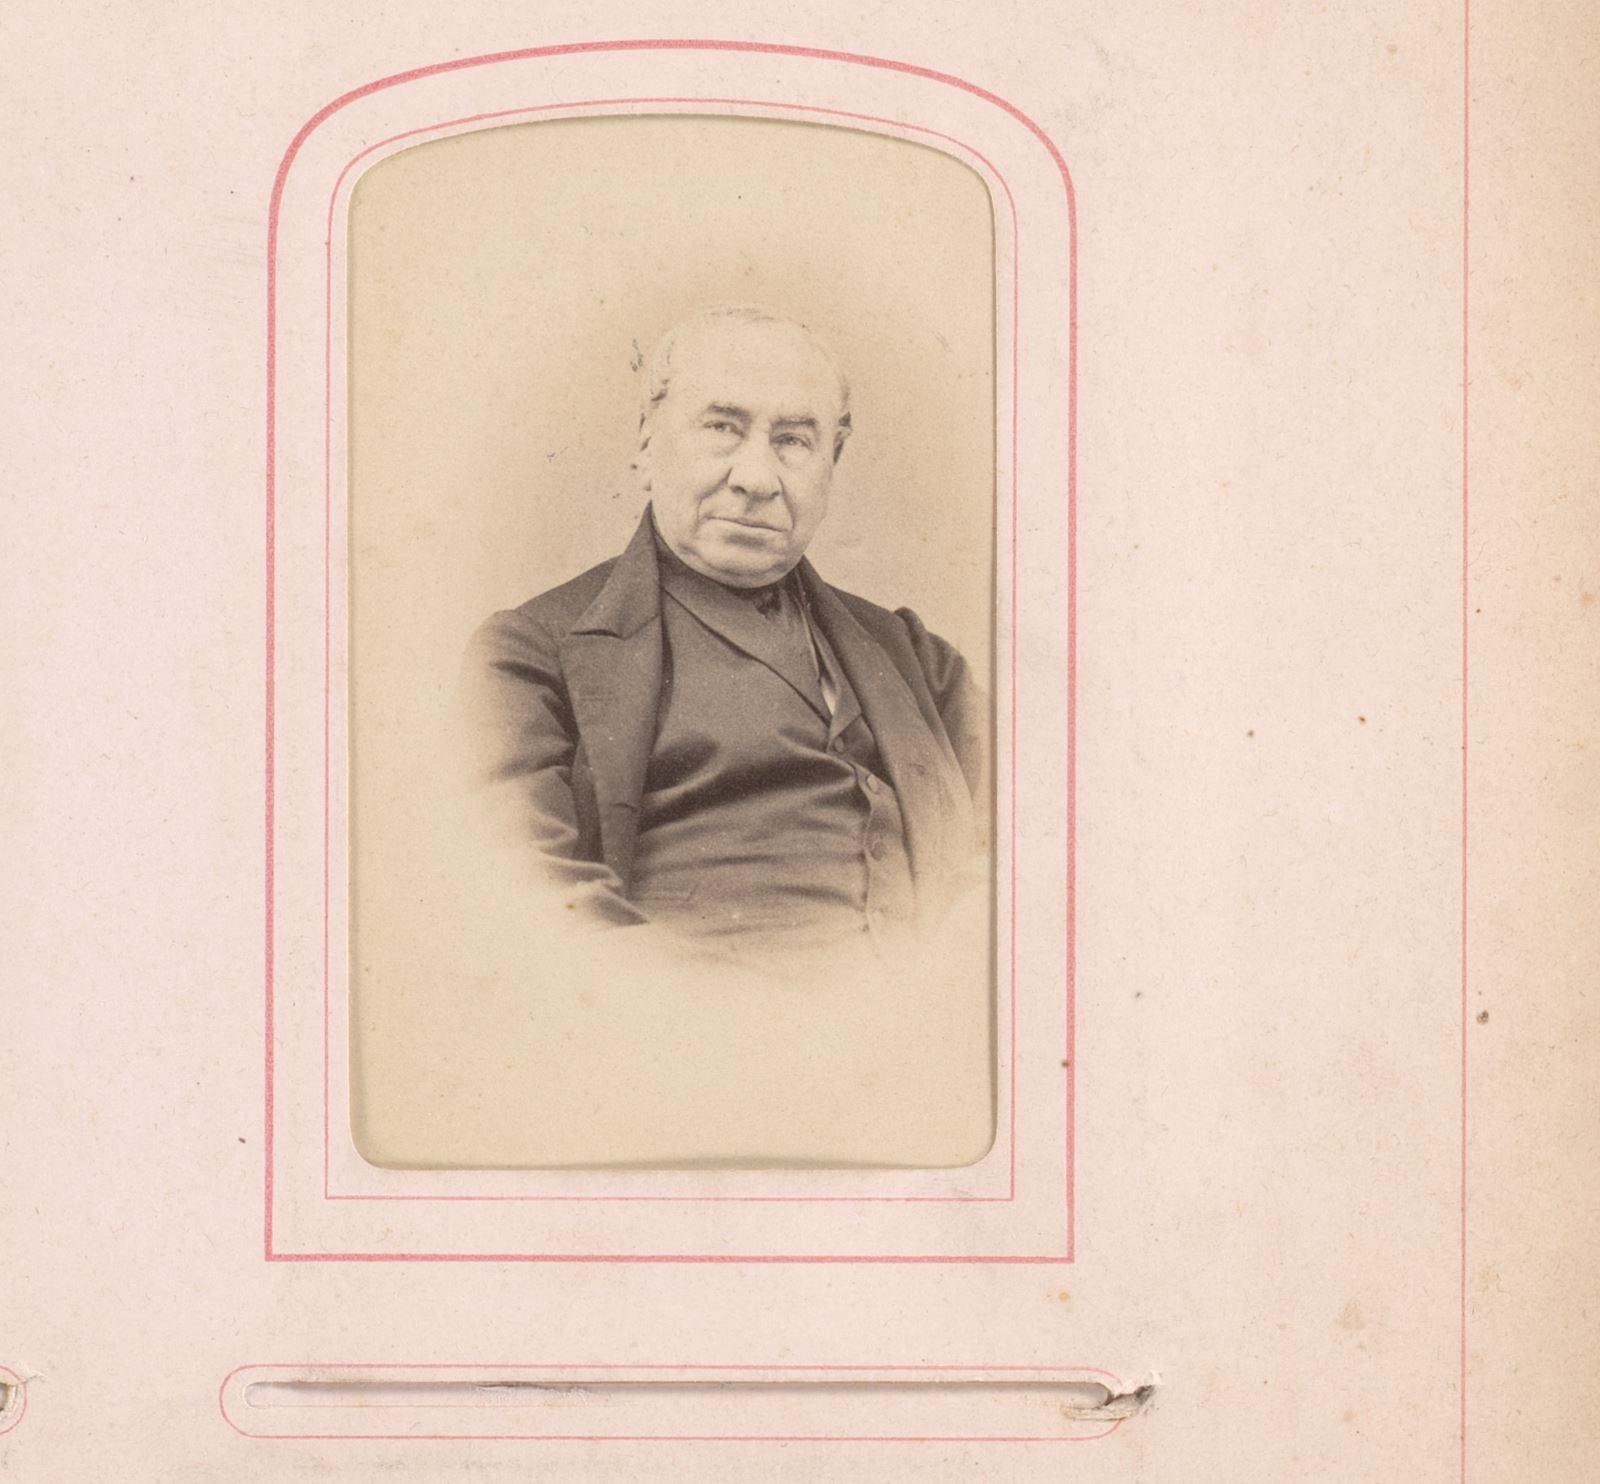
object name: album leaf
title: Nederland, buste man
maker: Anonymous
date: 1855-1885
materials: cardboard, paper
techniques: albumen print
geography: netherlands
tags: adult man, historical persons, netherlands